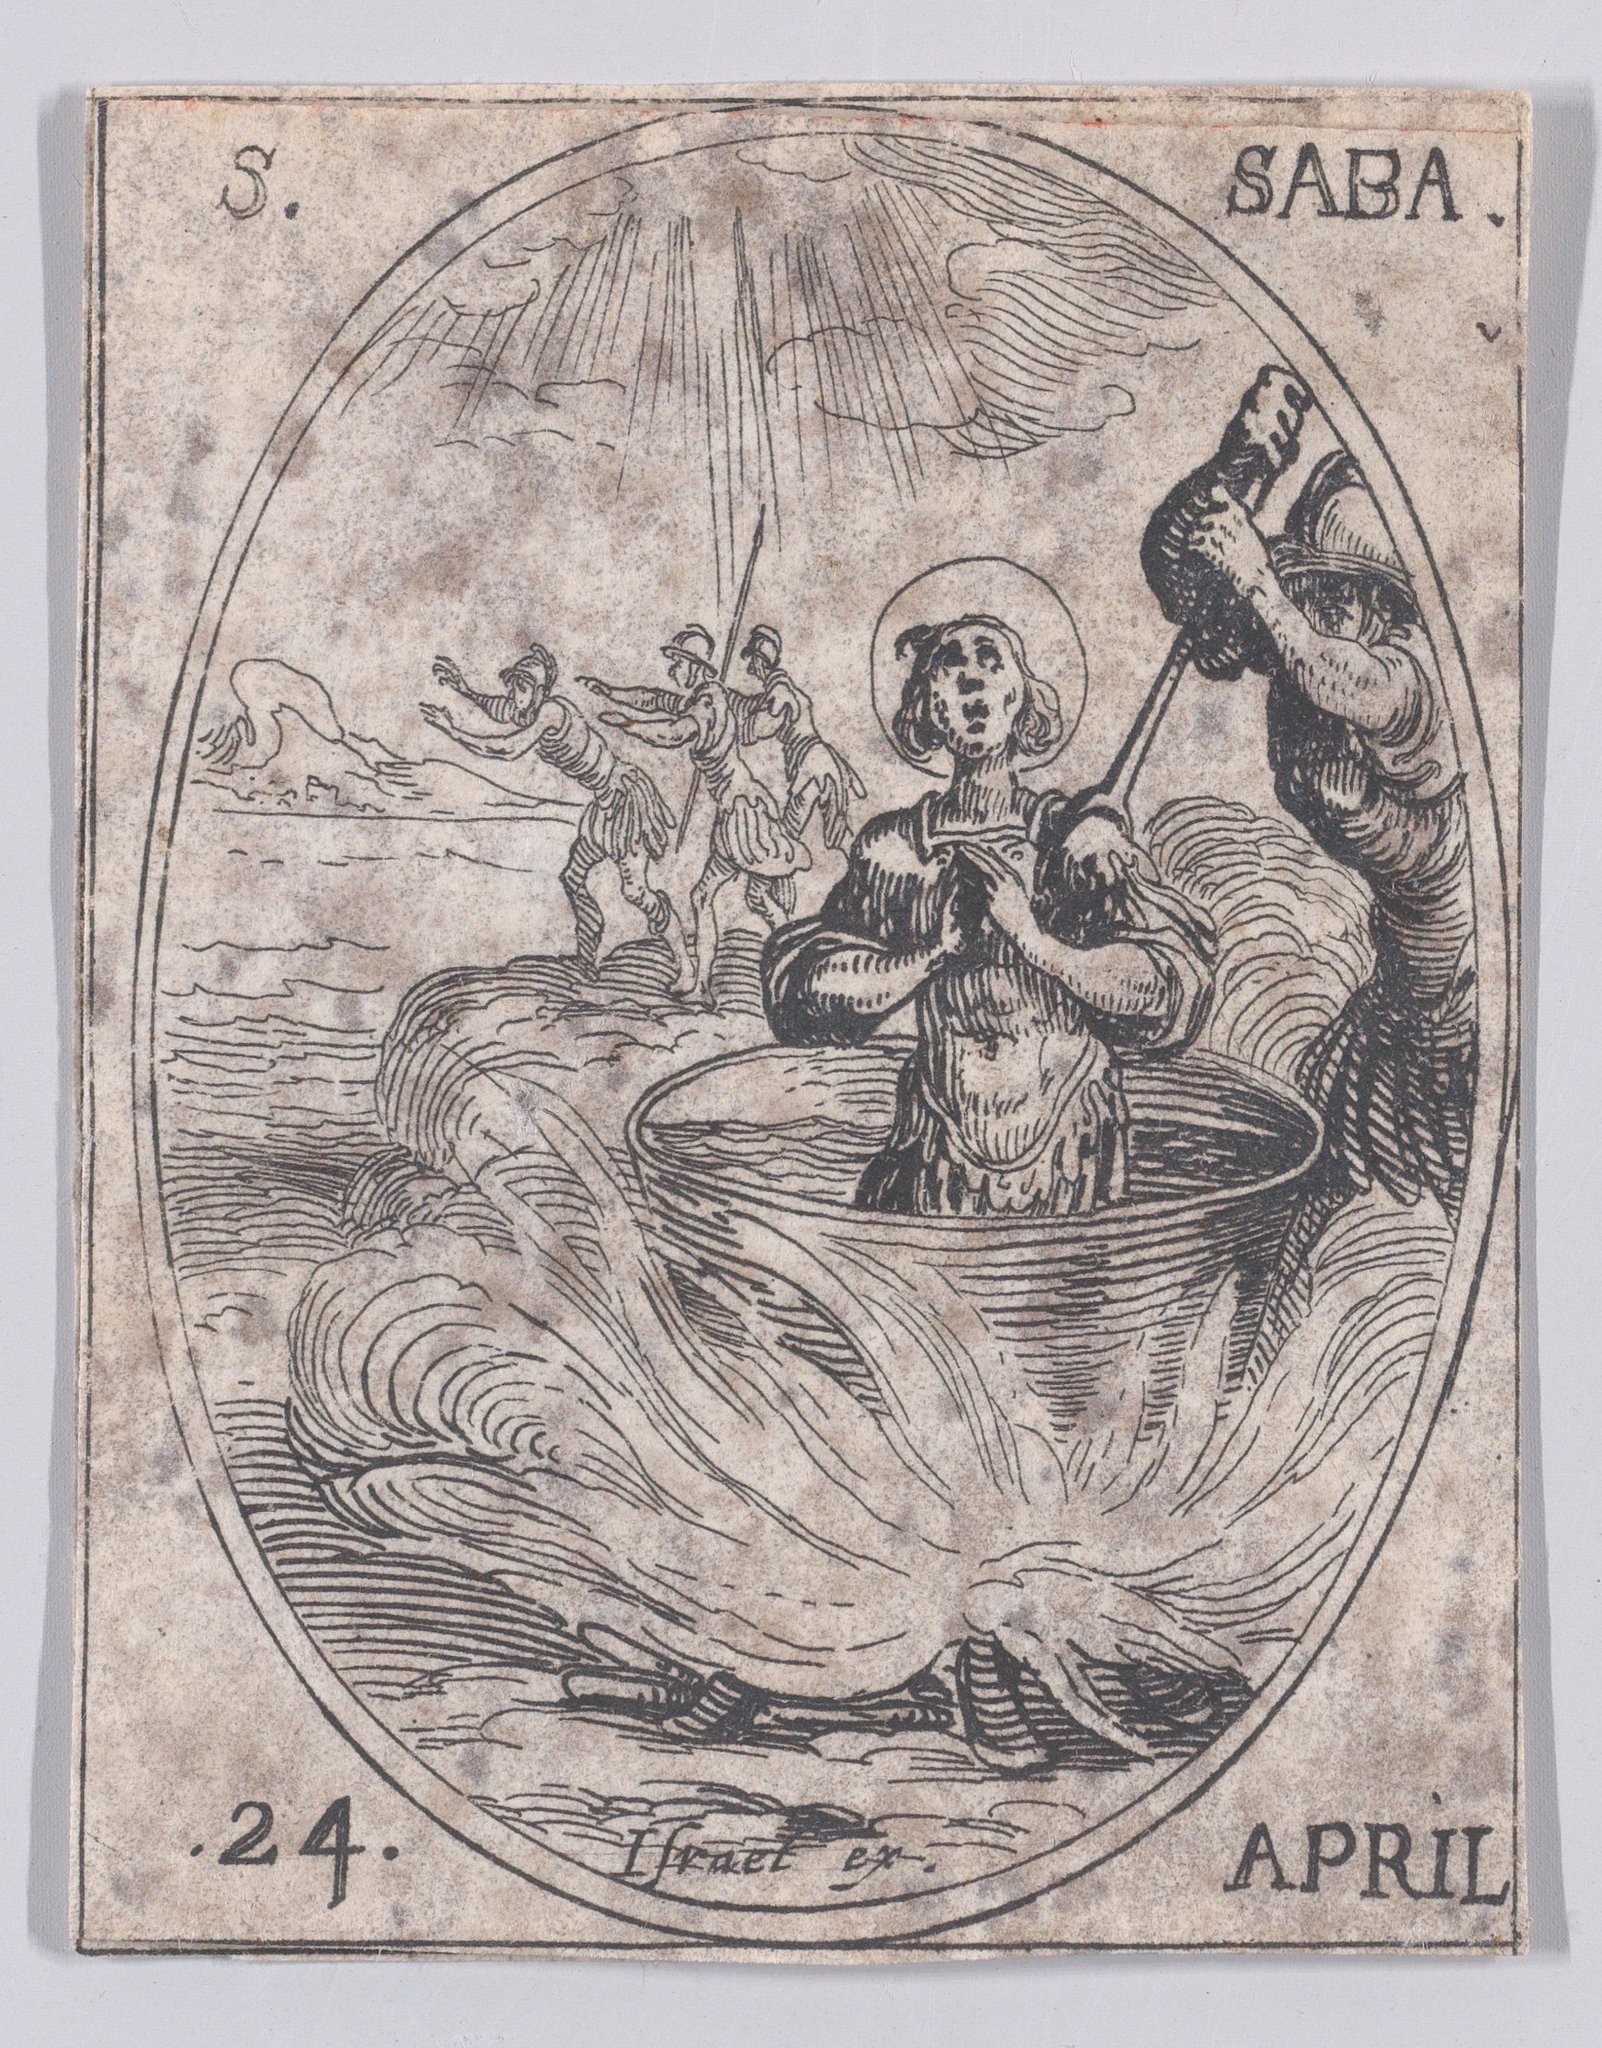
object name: print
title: S. Saba (St. Sabas), April 24th, from "Les Images De Tous Les Saincts et Saintes de L'Année" (Images of All of the Saints and Religious Events of the Year)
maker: jacques callot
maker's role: artist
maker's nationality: french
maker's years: 1592-1635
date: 1636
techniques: etching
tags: men,saints